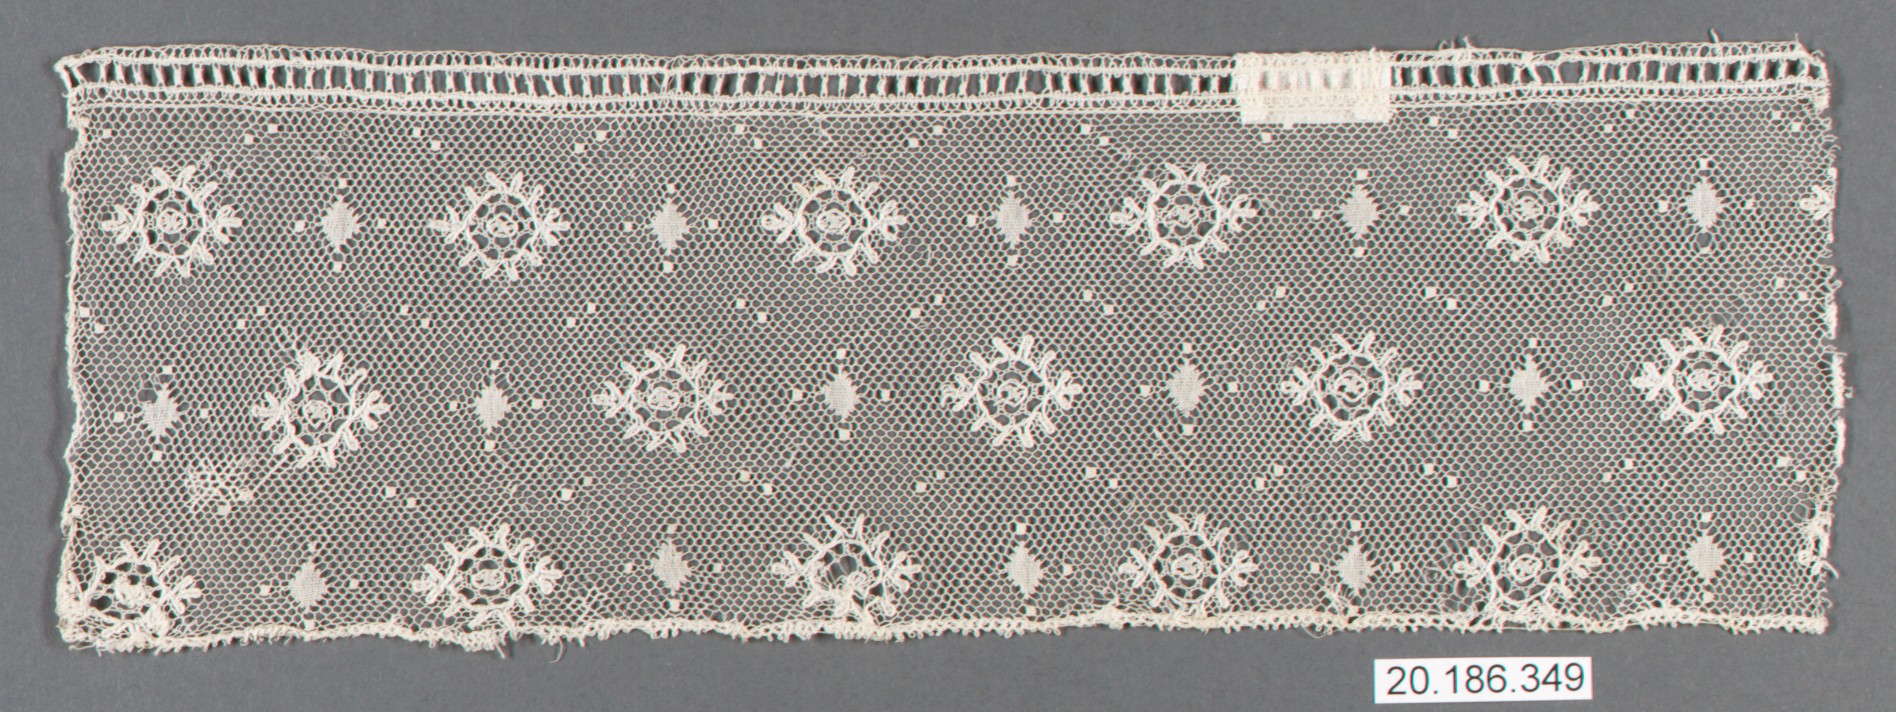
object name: strip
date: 1801-1833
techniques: lace